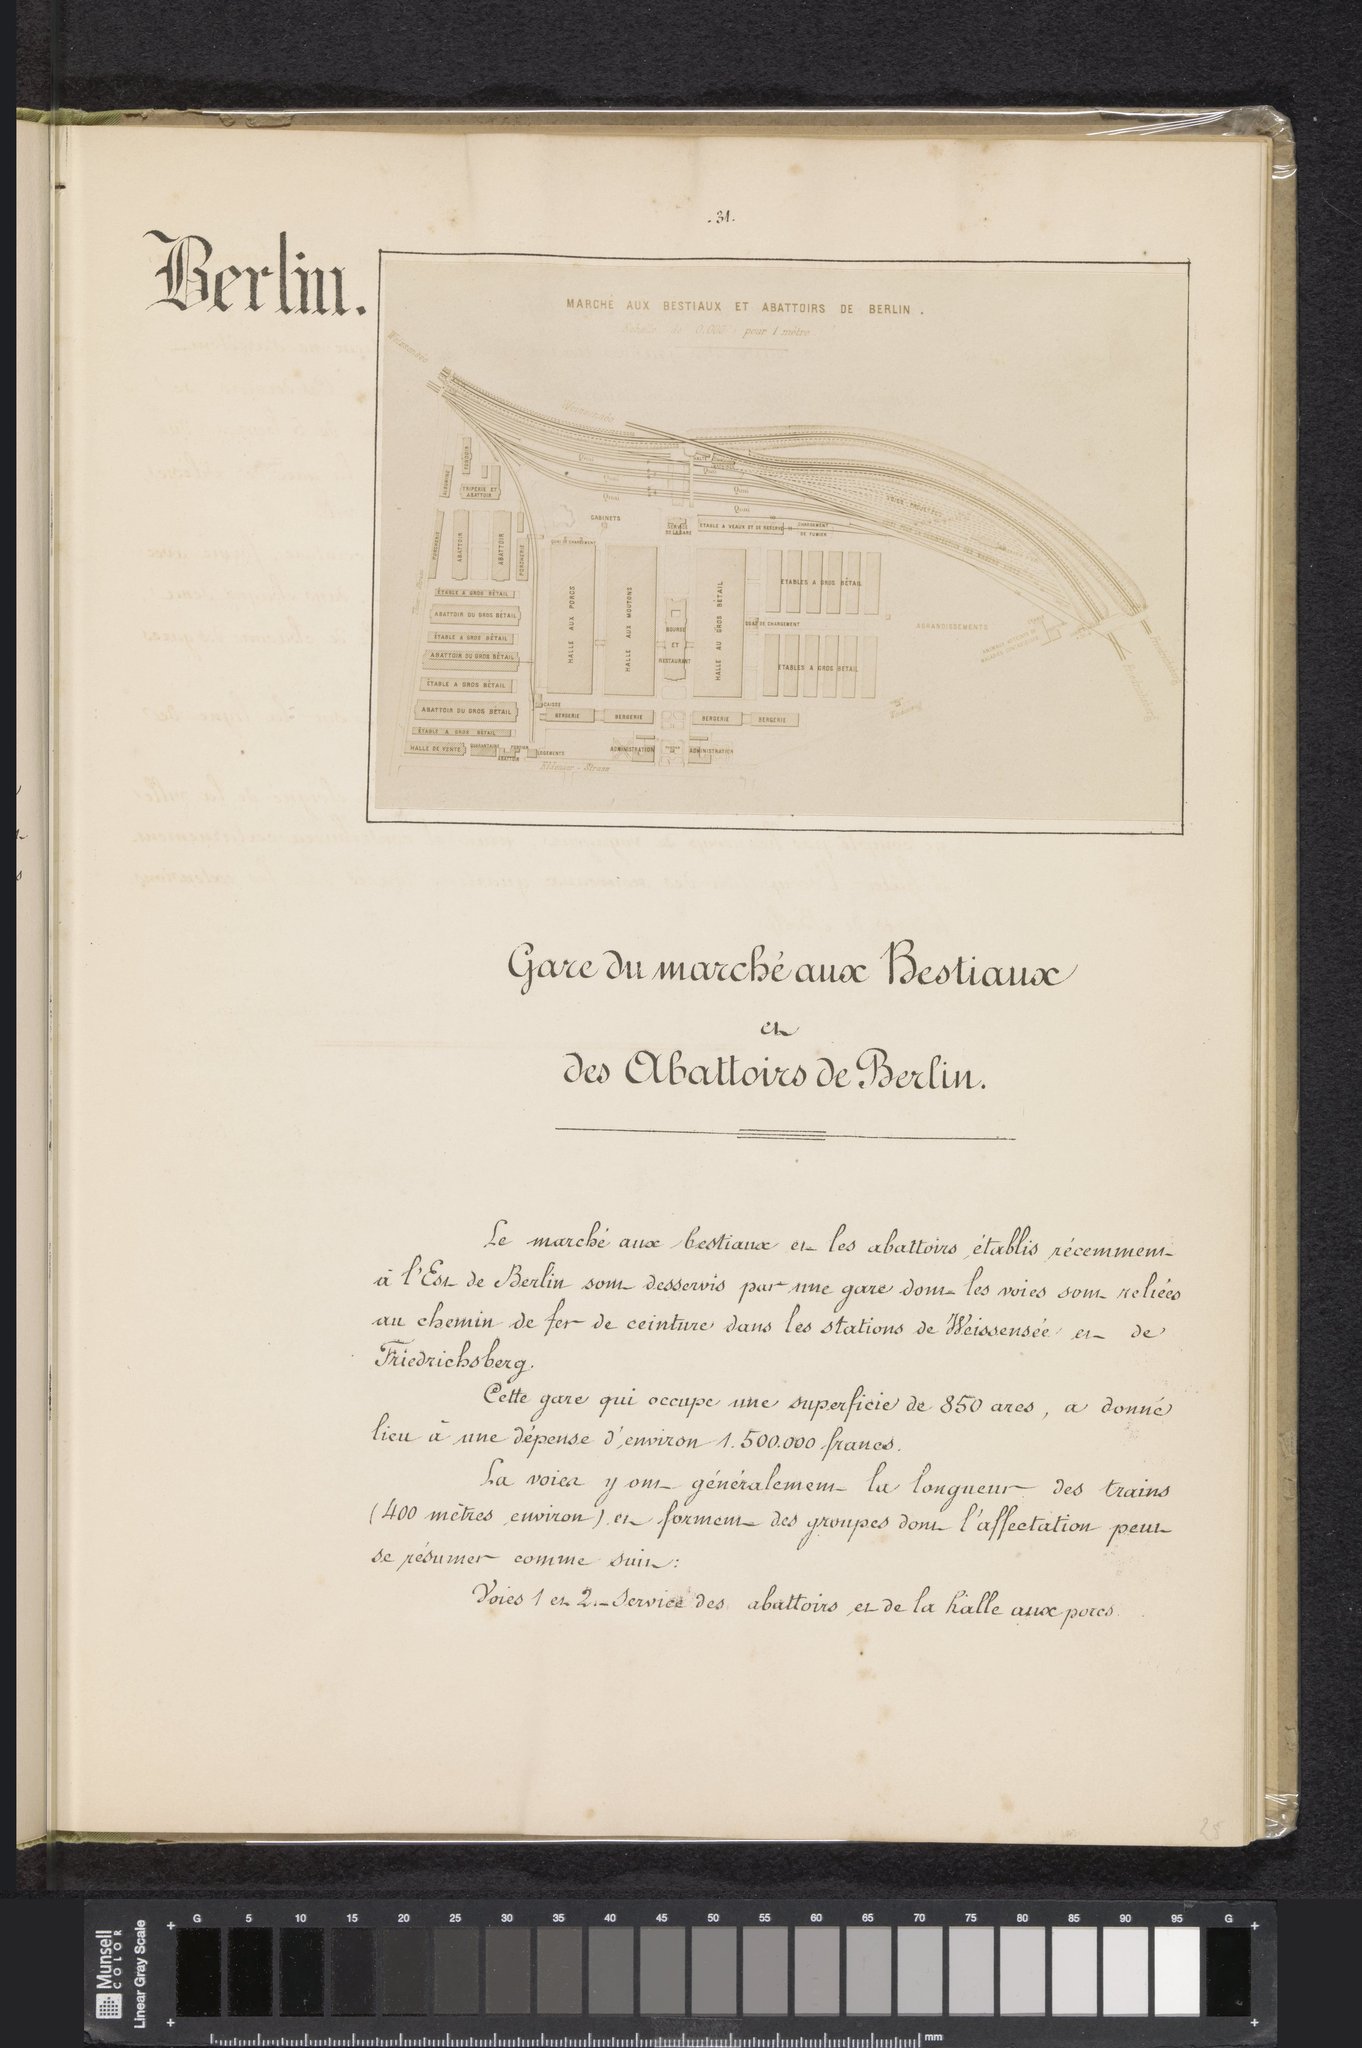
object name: page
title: Fotoreproductie van een kaart van het slachtterrein te Berlijn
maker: Anonymous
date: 1874-1884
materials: photographic support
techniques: albumen print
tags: maps, atlases, butcher, slaughterman